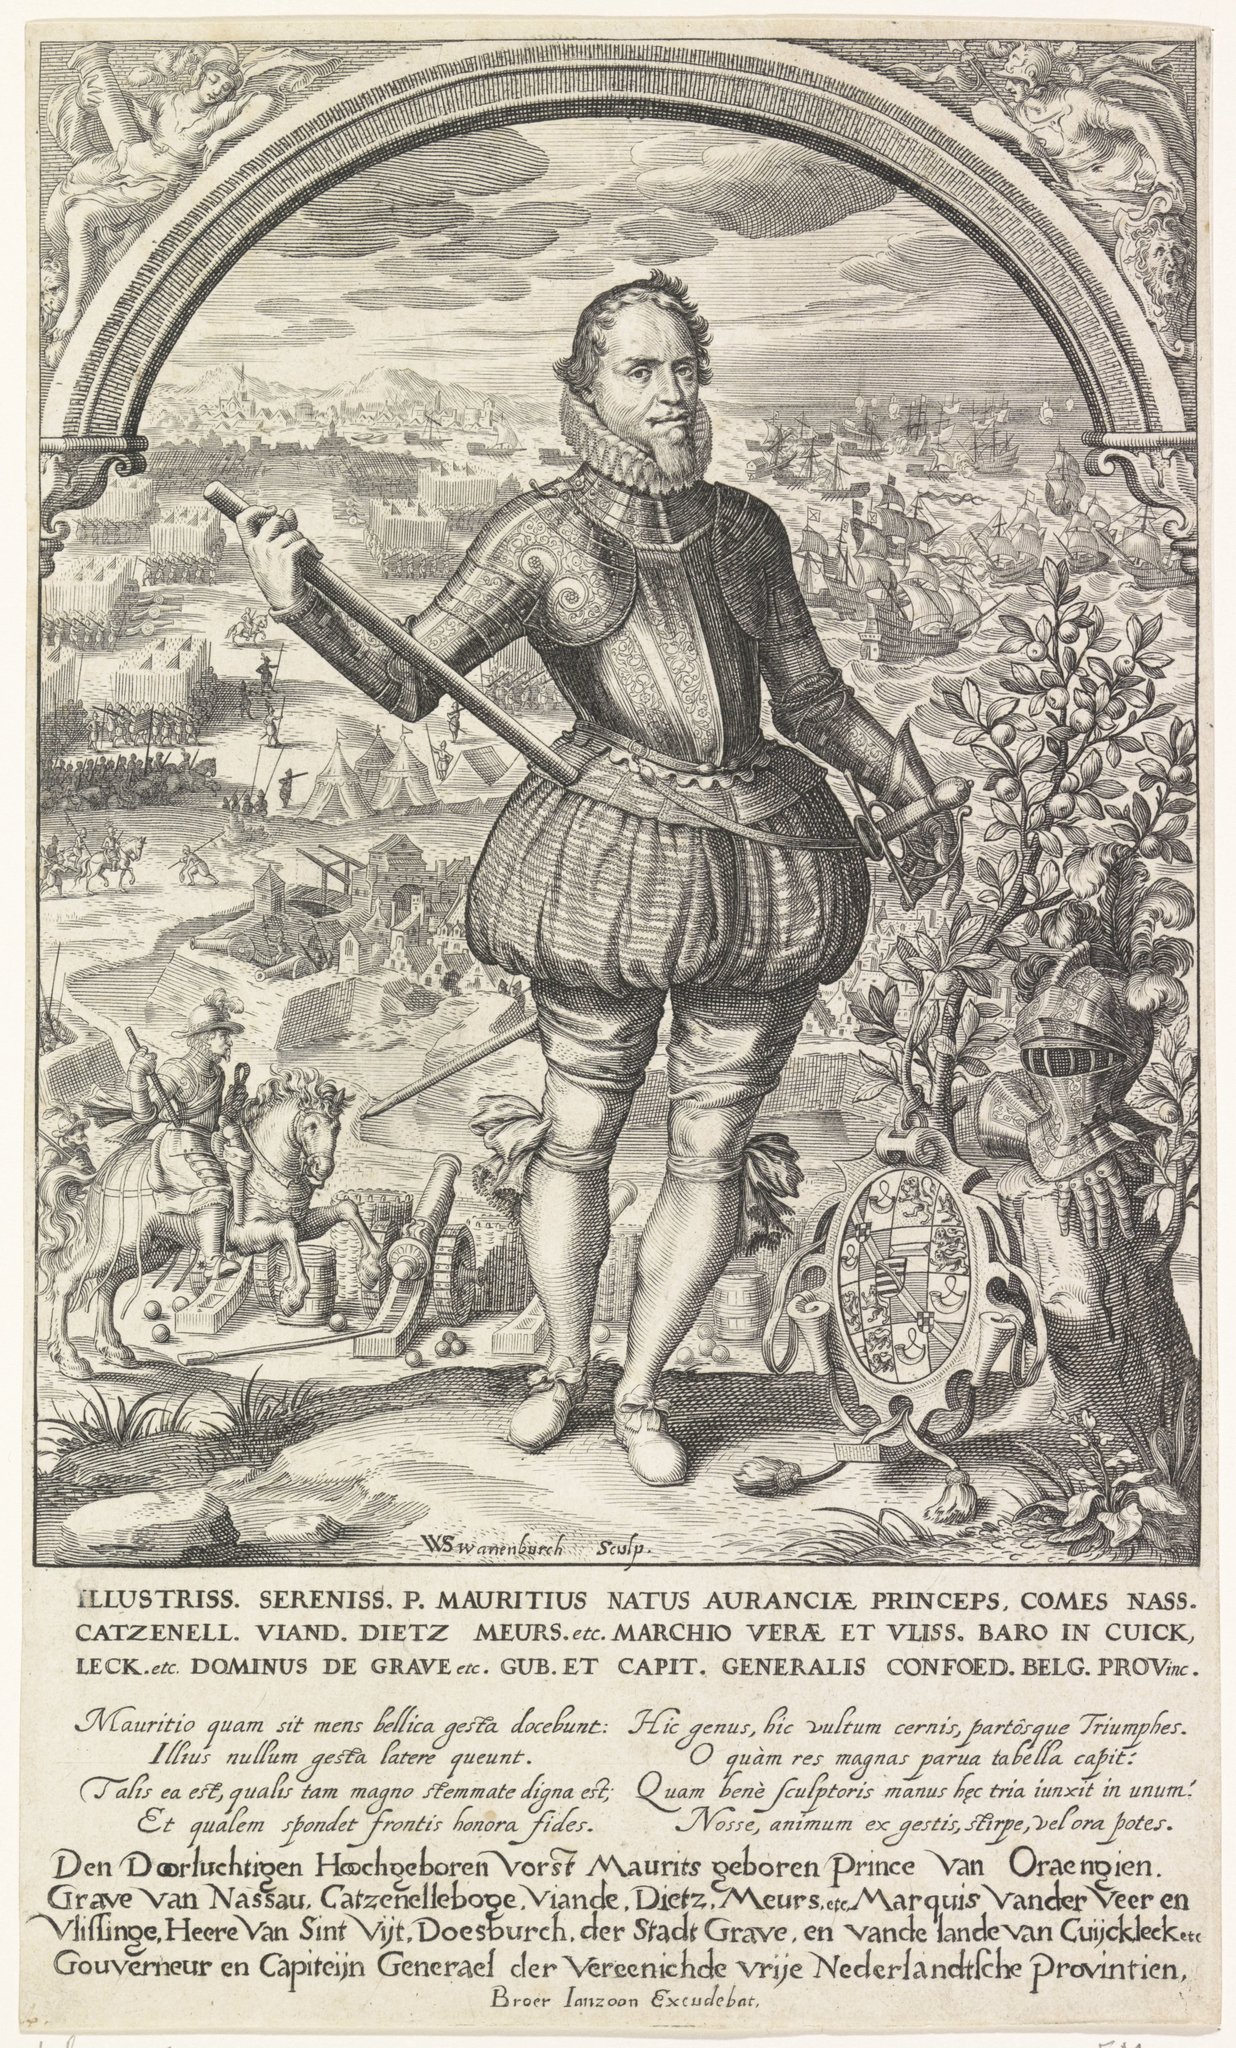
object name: print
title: Portret van Maurits, prins van Oranje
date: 1600-1602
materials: paper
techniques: engraving, etching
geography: leiden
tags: the hague, maurice (prince of orange), battle of nieuwpoort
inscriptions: collector's mark: Lugt 963, collector's mark: Lugt 2228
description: Portret van Maurits onder een toog. In de rechterhand een commandostaf. Op de achtergrond de Slag bij Nieuwpoort, 2 juli 1600. In de ondermarge zijn naam in het Latijn, twee kolommen met elk vier regels Latijnse tekst en zijn naam in het Nederlands.